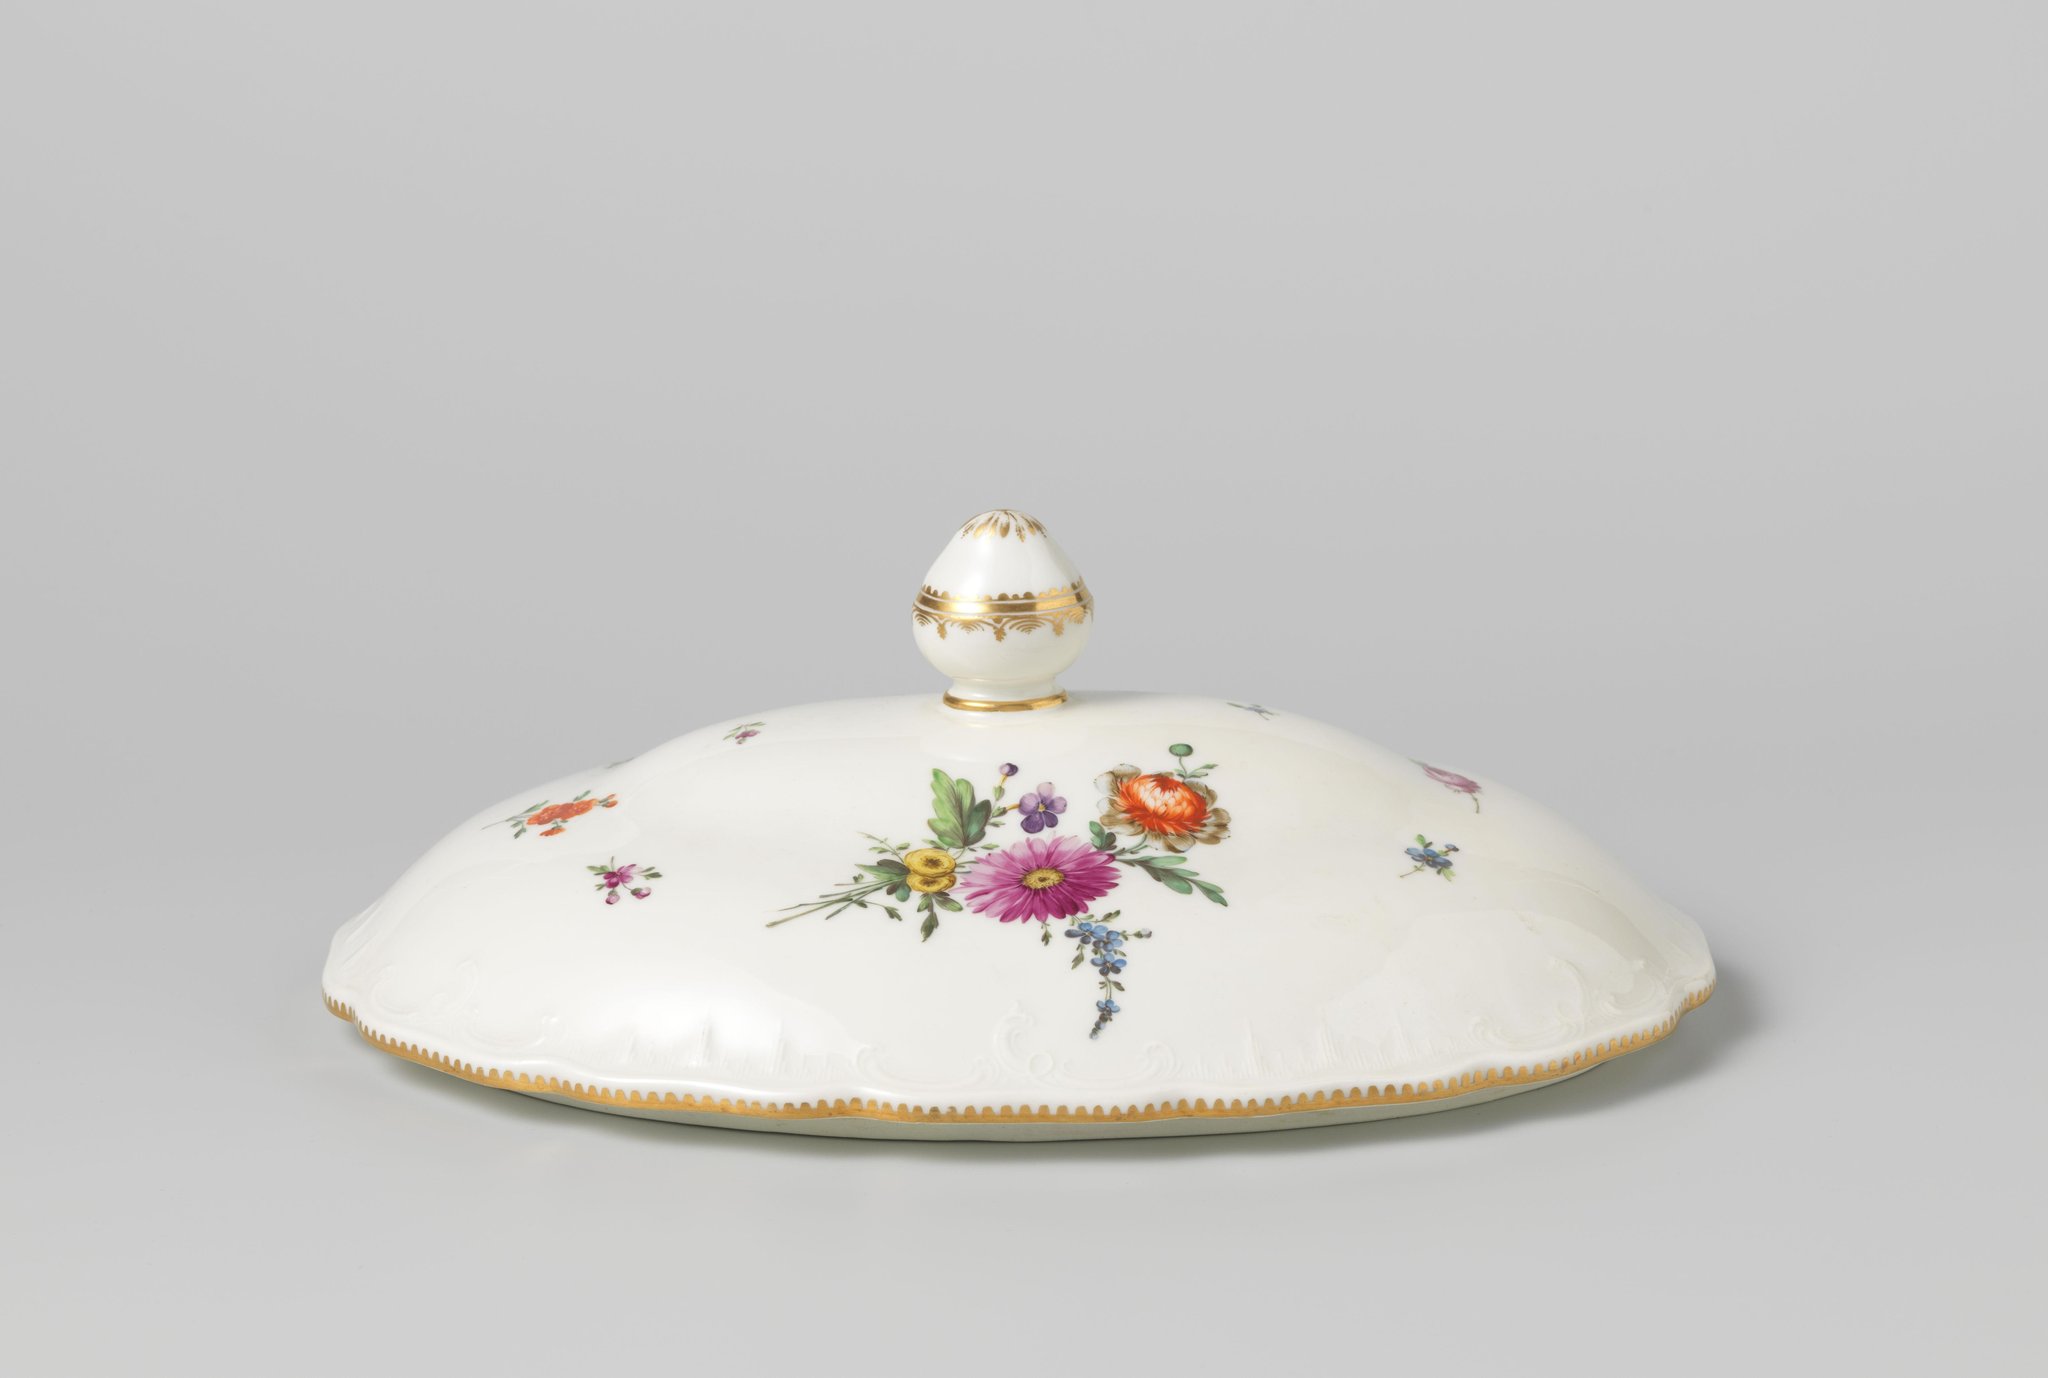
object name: lid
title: Deksel van porselein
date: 1774-1784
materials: porcelain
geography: loosdrecht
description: Deksel van porselein. Beschilderd met boeketten en strooibloemen.